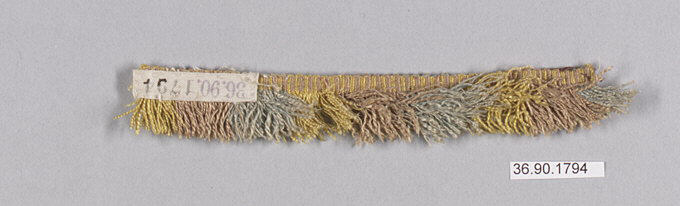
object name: fringe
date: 1801-1833